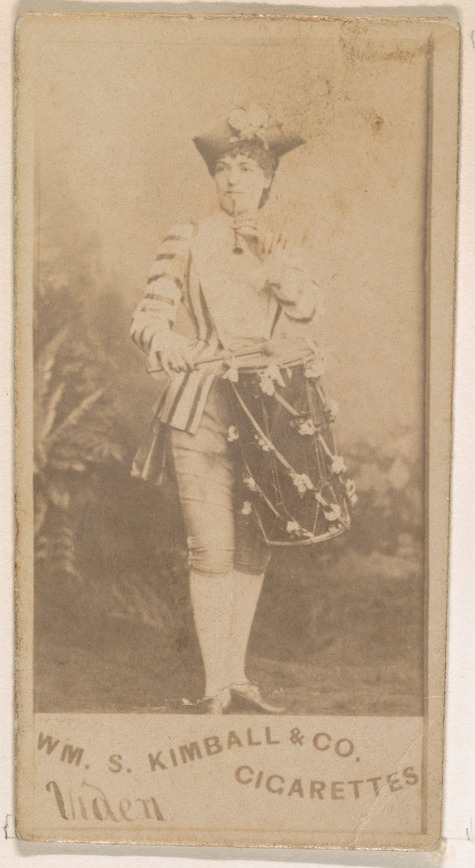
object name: photograph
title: Miss Viden, from the Actresses series (N203) issued by Wm. S. Kimball & Co.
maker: william s. kimball & company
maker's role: publisher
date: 1889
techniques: color lithograph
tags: portraits,women,actresses